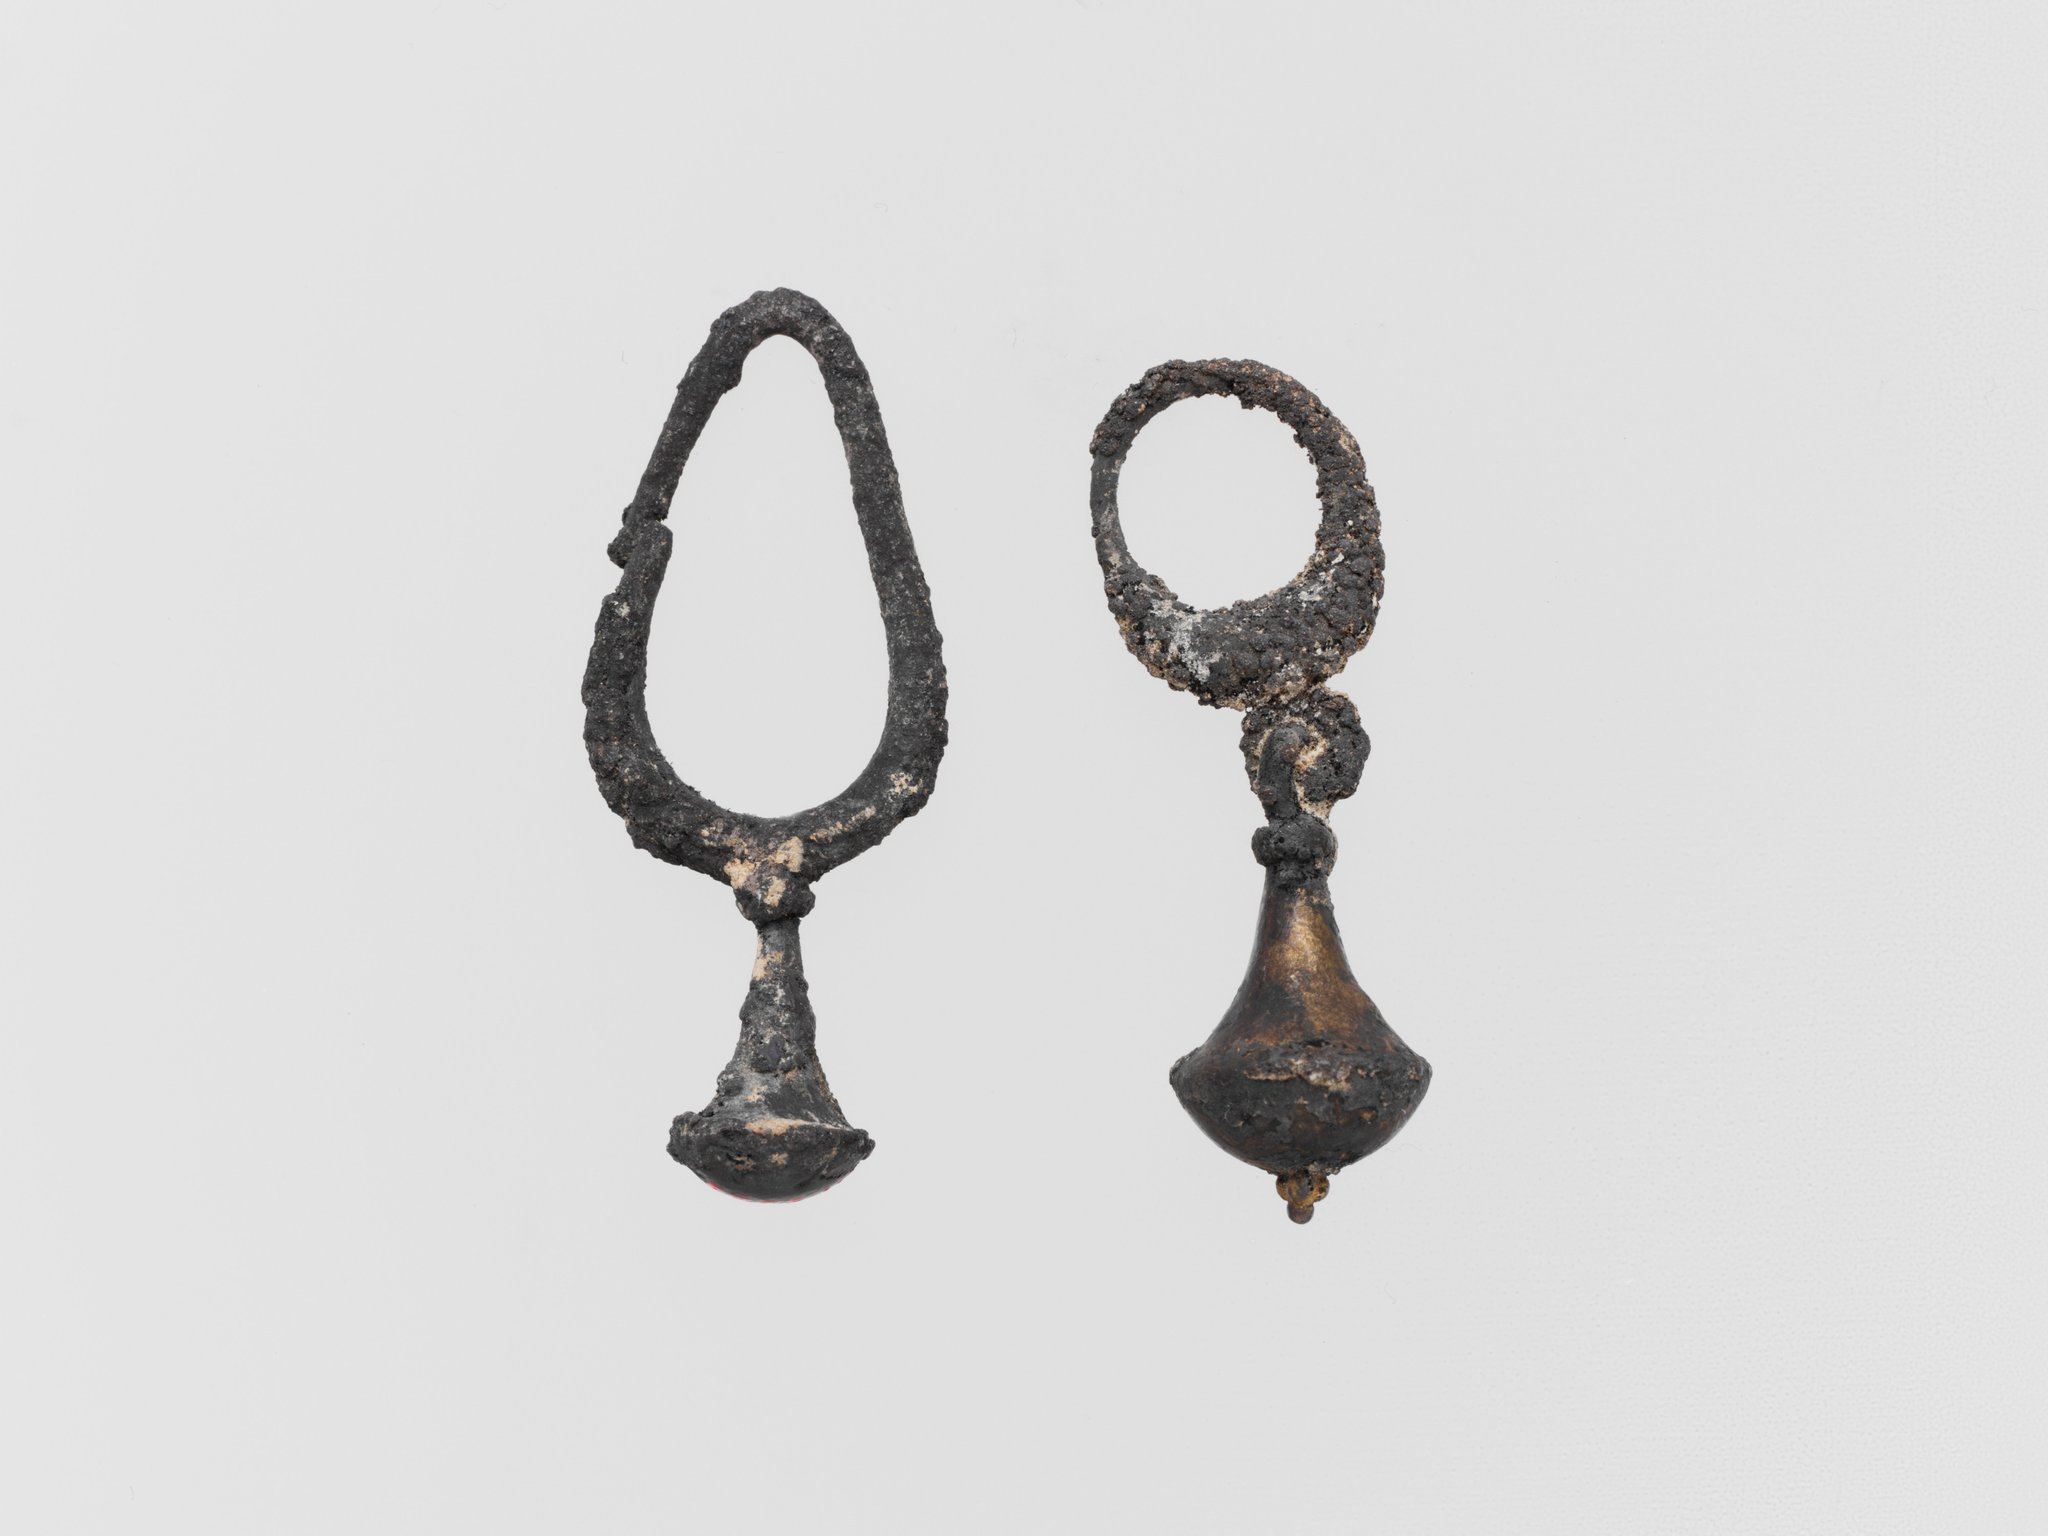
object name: earring with nail head pendant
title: Silver earring with nail-head pendant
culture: cypriot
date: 600-501 BCE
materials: silver